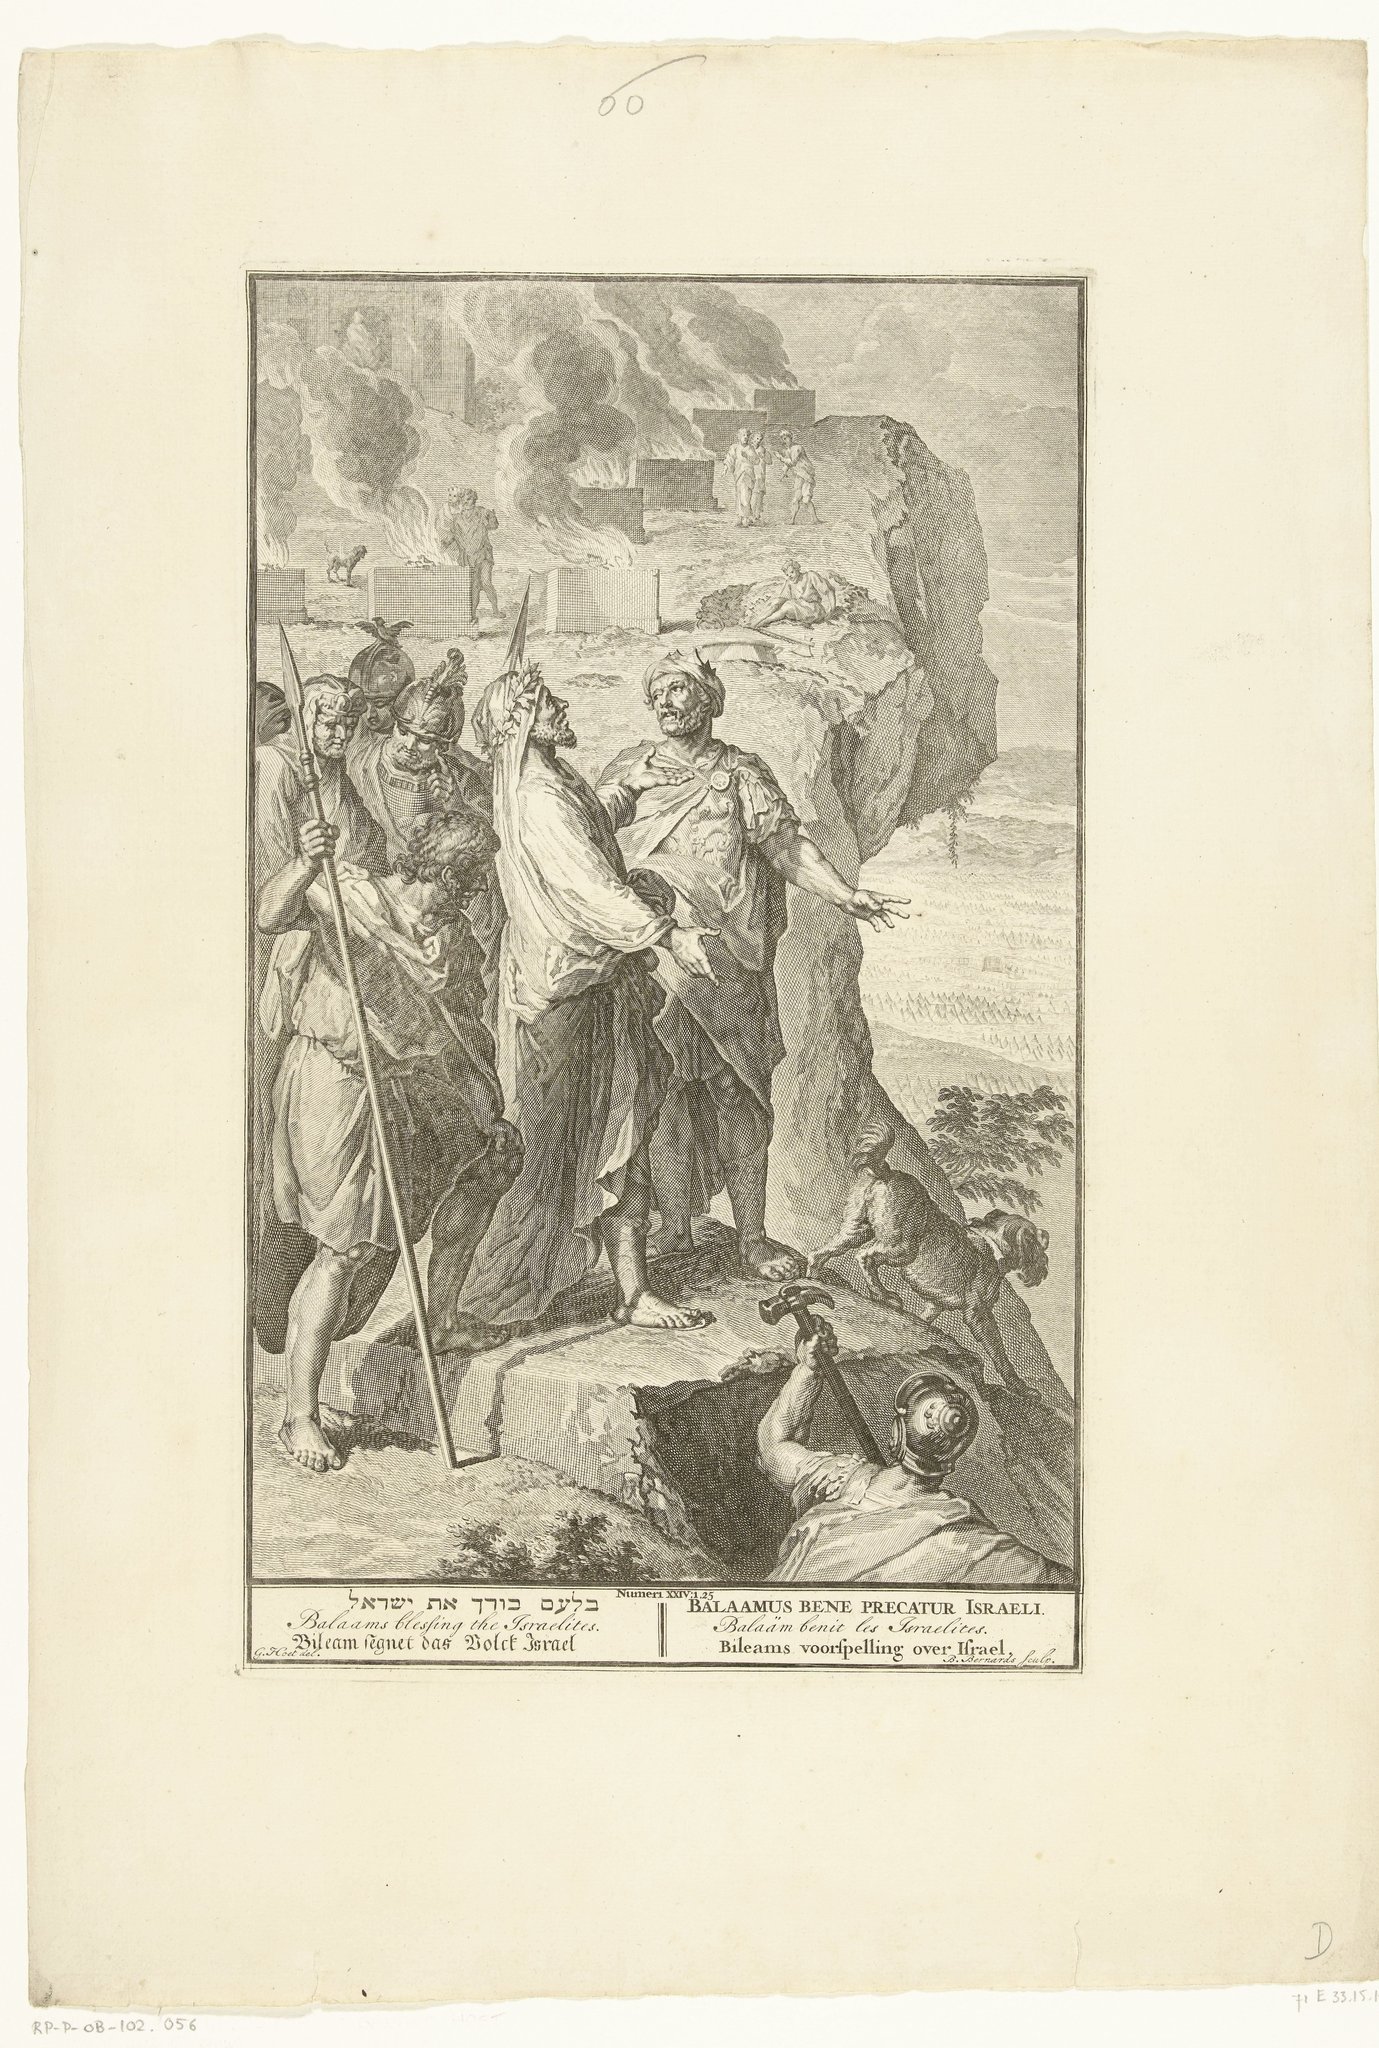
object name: print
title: Bileam spreekt zijn orakel uit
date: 1720-1728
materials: paper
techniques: engraving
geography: amsterdam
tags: balaam sacrificing the seven bulls and the seven rams in the presence of king balak, balaam prophesying and blessing the israelites in the presence of king balak and his chieftains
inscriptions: collector's mark: Lugt 2228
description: Prent gemaakt voor: Figures de la Bible. Amsterdam, Bernard Picart, 1720. Prent ook gebruikt in: Taferelen der voornaamste geschiedenissen van het Oude en Nieuwe Testament (...) door de vermaarde kunstenaars Hoet, Houbraken, en Picart getekent (...) en met beschrijvingen uitgebreid. Den Haag: Pieter de Hondt, 1728.